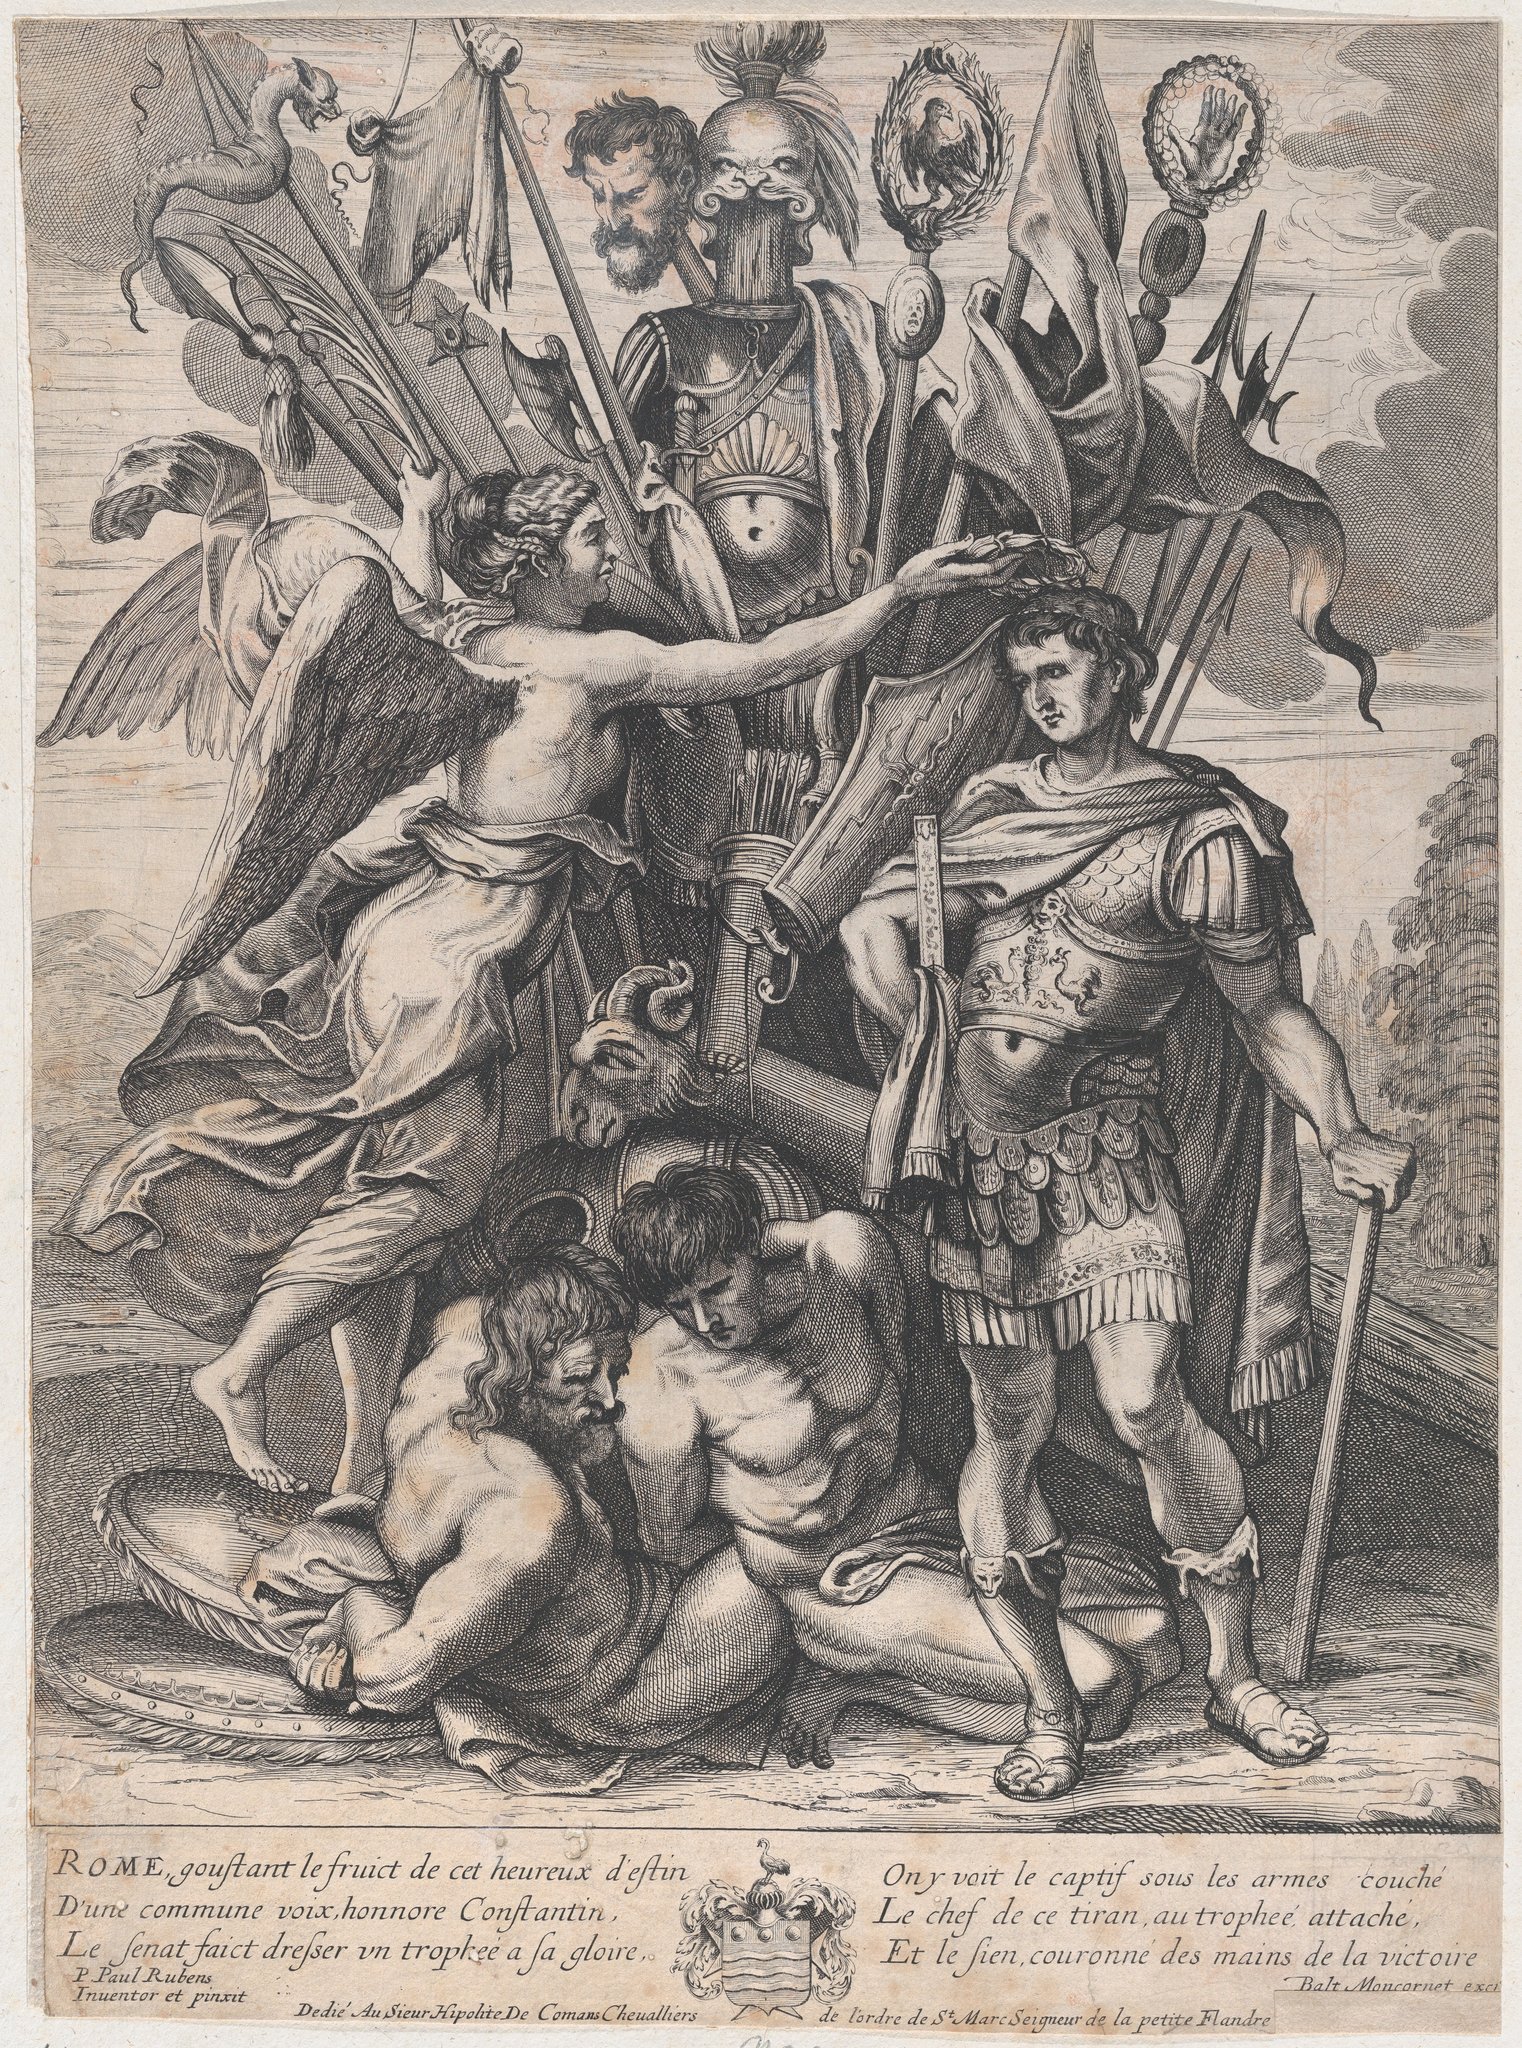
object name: print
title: The Trophy of Constantine, with Victory at left crowning the emperor with a laurel, behind them a bounty of arms, armor, prisoners, and Maxentius' head on a stick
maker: Anonymous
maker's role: artist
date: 1650-1668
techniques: engraving, etching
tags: soldiers,armor,weapons,men,trophies